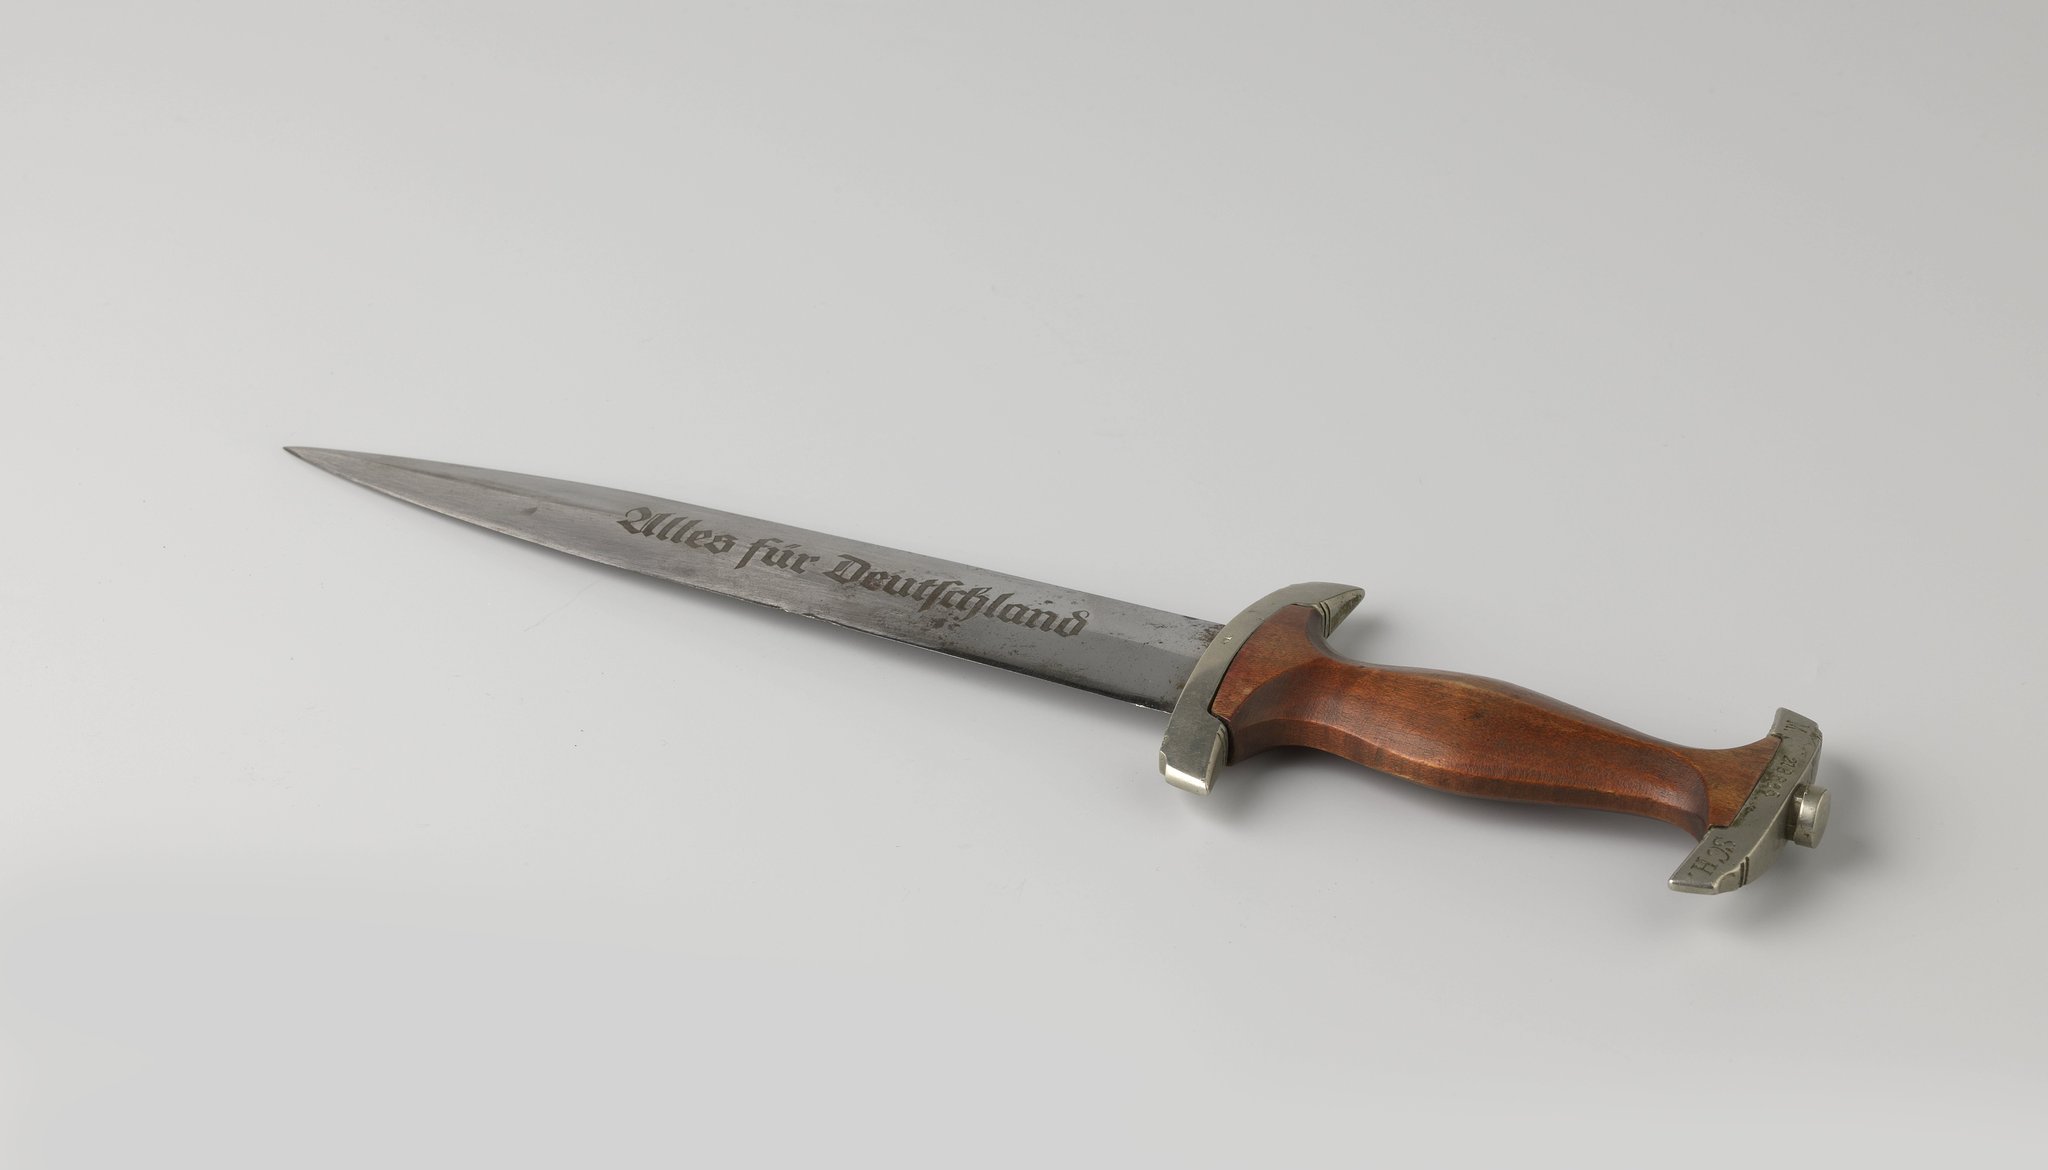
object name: dagger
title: SA-dolk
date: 1933-1940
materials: metal, wood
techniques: forging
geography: germany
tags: the hague, dick w.b. van maarseveen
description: Dolk met kastanjekleurig houten greep. Kling en beslag zijn van diverse metaalsoorten. Op het lemmet inscriptie in gotische letters: 'Alles für Deutschland'. Op de stootplaat inscriptie 'm'. Op de greep zit een inkeping waar voorheen een adelaartje bevestigd zat. Ook op lemmet fabrikagegegevens, Solingen. De punt is afgebroken geweest en later bijgeslepen. Op greepknop SA-monogram, wapennummer '218865' en initialen eigenaar 'M. Sch.'